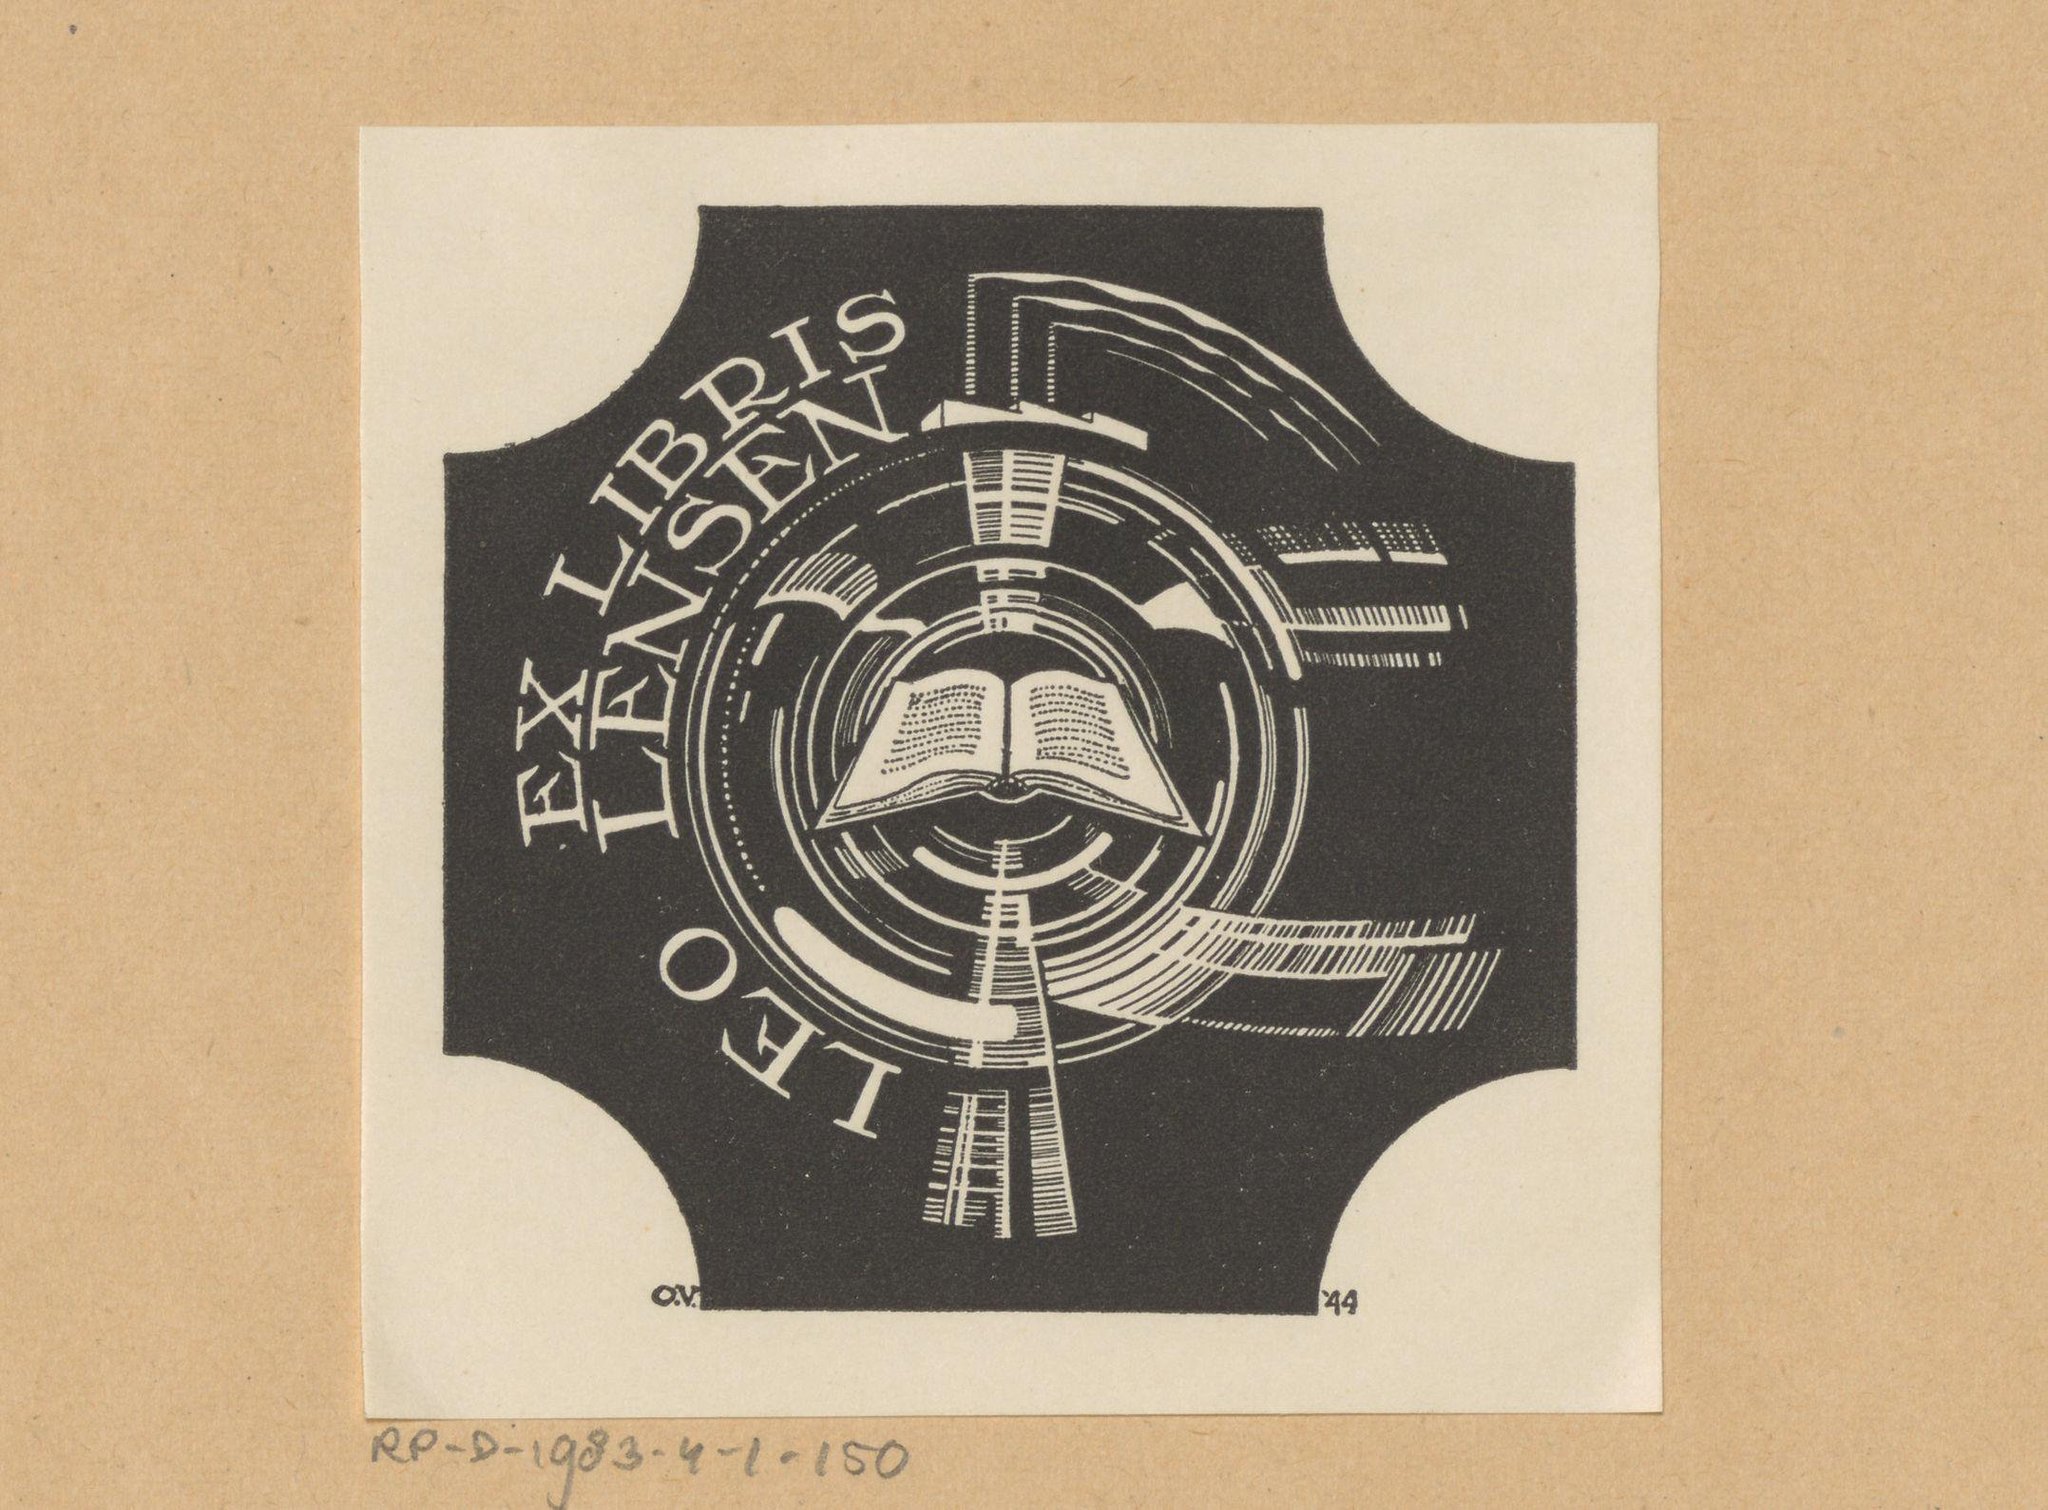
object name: bookplate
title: Ex libris van Leo Lensen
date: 1944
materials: paper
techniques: printing block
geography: netherlands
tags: factory-building, motorcar racing, book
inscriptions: inscription: ‘Clichédruk 1944. Eigenaar (...) snelheids-begrip geven.’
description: Eigenaar van het ex libris was fabrieksdirecteur en liefhebber van raceauto's. De voorstelling verbeeldt de fabriek en een draaiend autowiel; een indruk van het drukke leven van de eigenaar, met als rustgevend centrum "het boek". Voorstelling is geïnspireerd op de film "Berlin" van Walter Ruttmann waarin opnames van sneldraaiende autowielen het snelheidsbegrip weergeven.